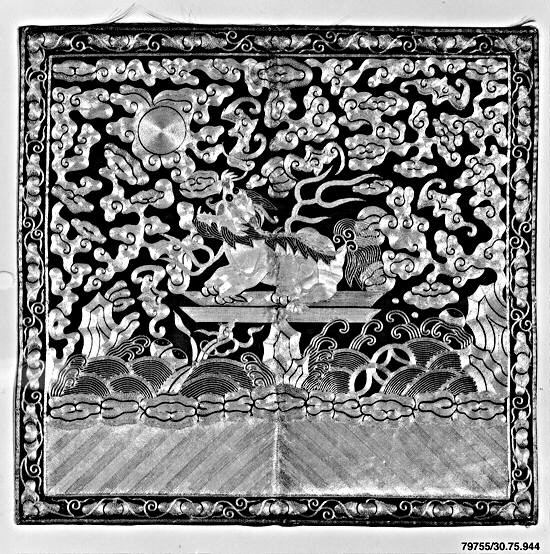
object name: rank badge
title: Rank Badge with Lion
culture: chinese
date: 1801-1900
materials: metal thread, silk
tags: bats,lions